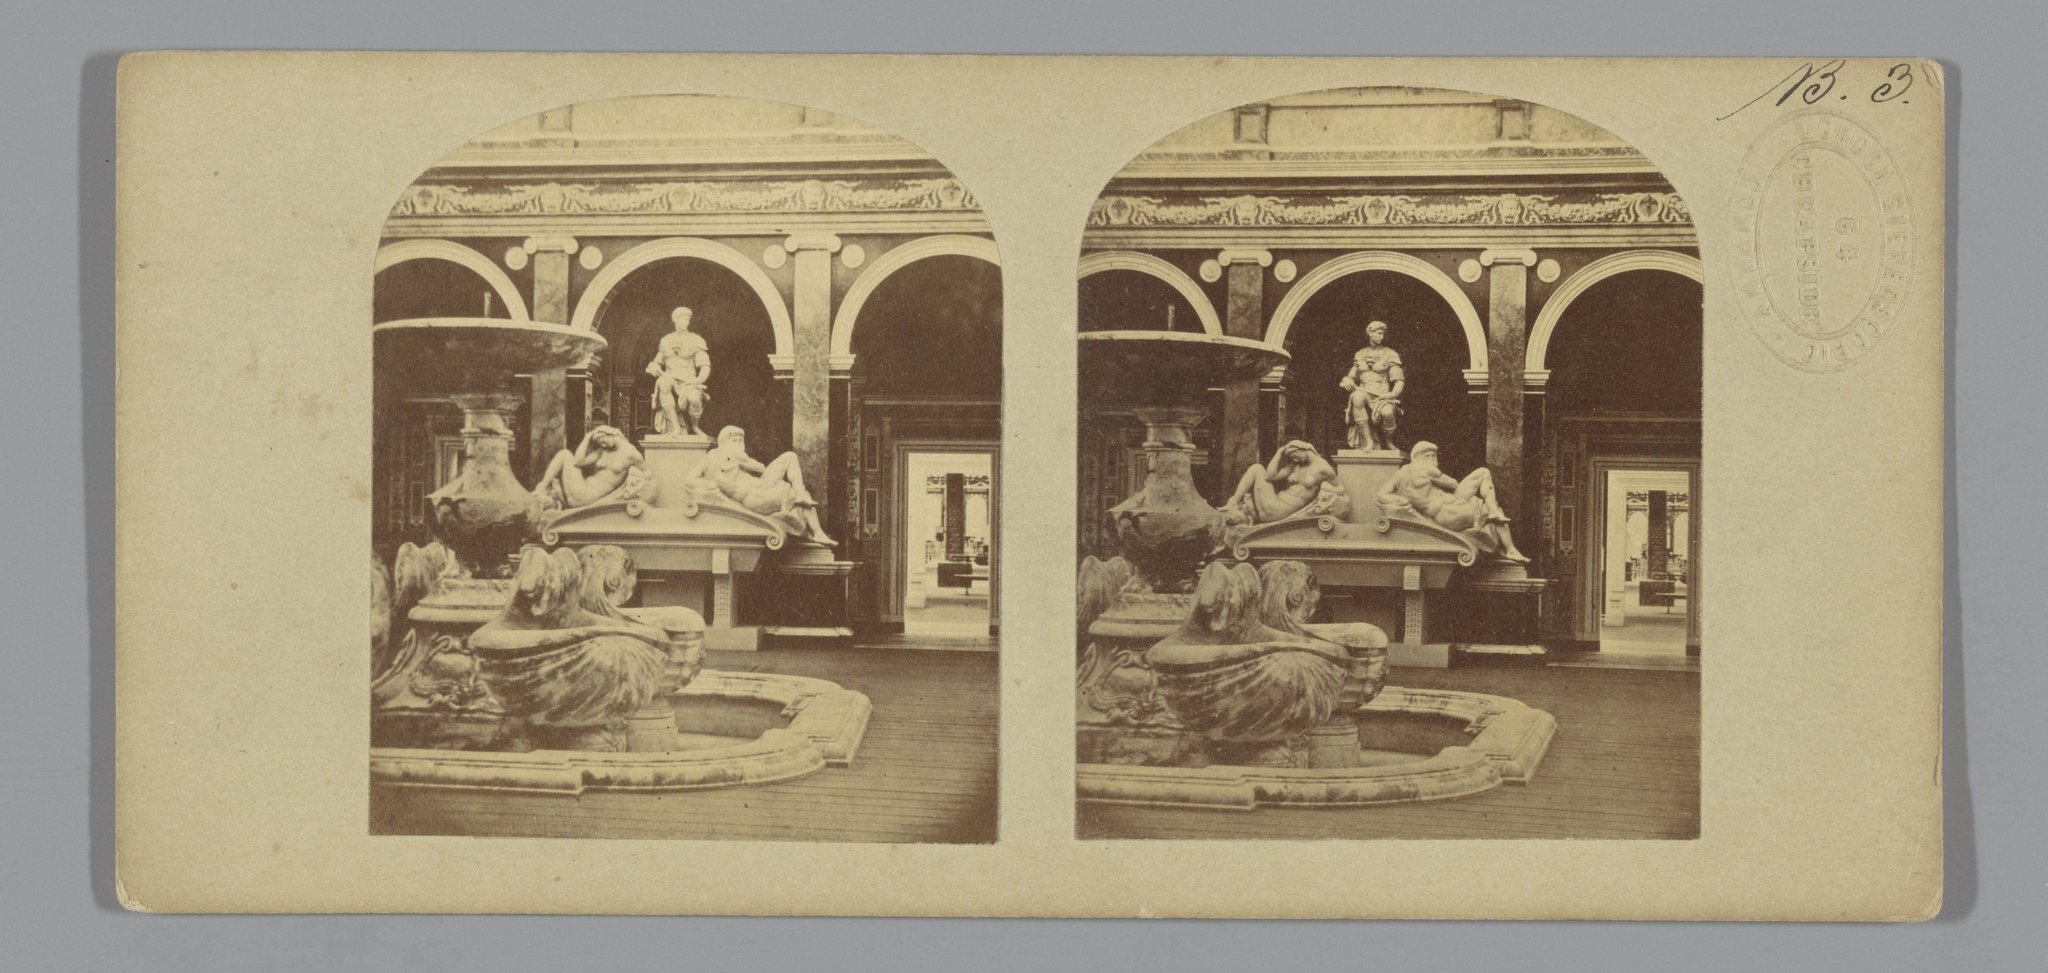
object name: stereograph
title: Gezicht in het Italian Court in het Crystal Palace in Londen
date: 1854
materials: cardboard, photographic support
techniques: albumen print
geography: crystal palace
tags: world fair, world exhibition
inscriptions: name: ‘London Stereoscopic Company 64 Chepside’, inscription: ‘B.B’, number: ‘No. 23.’, inscription